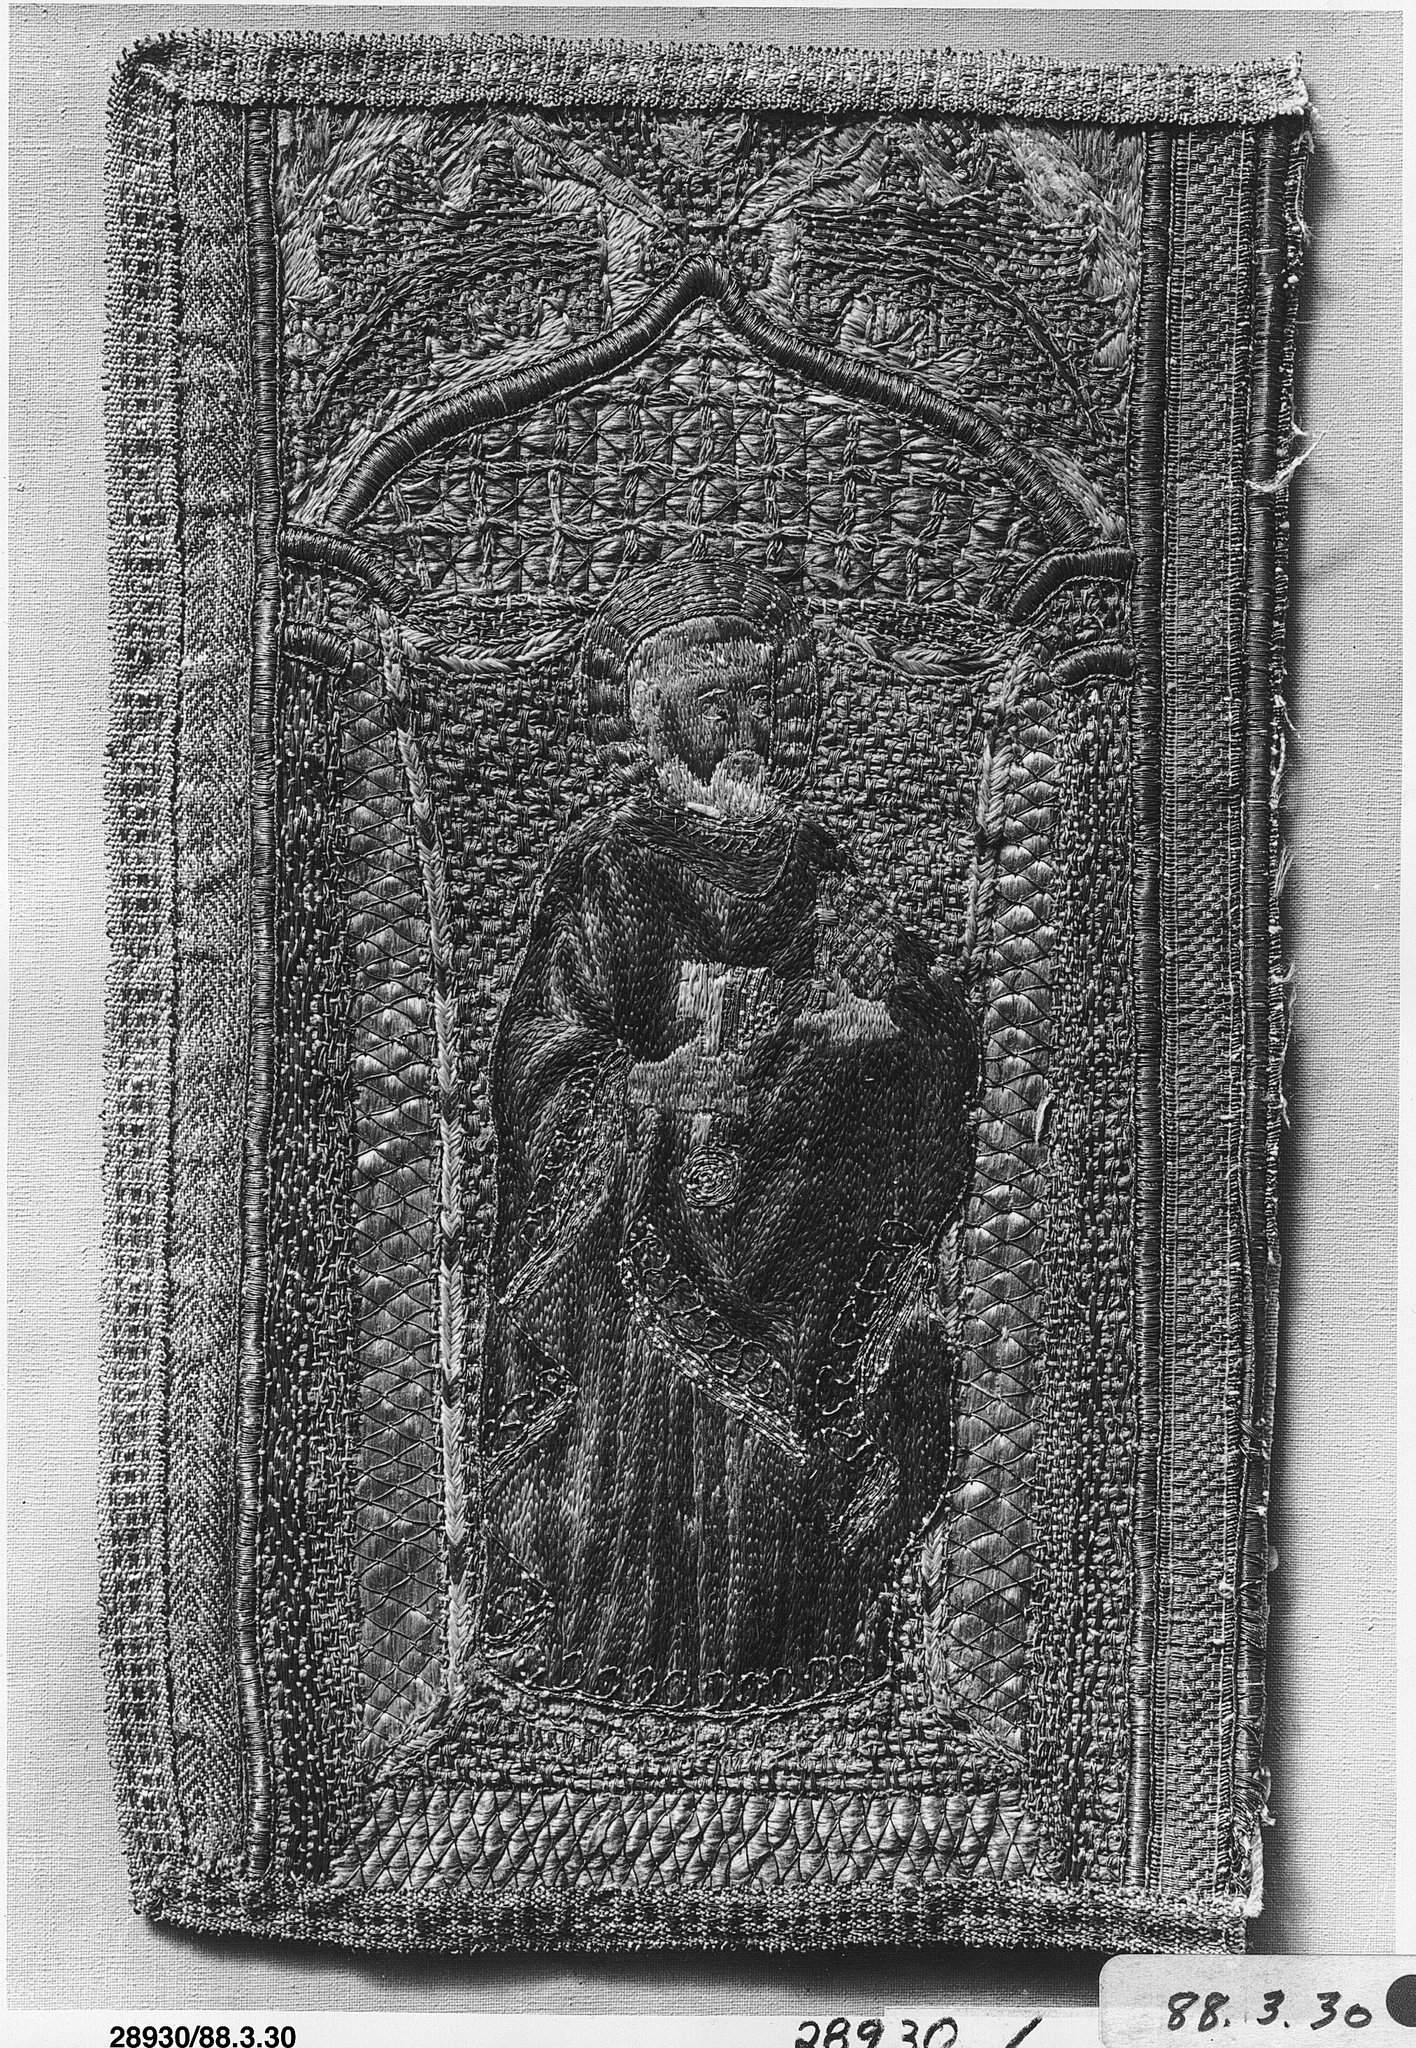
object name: panel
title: Saint Peter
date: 1401-1500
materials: metal thread, silk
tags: saint peter